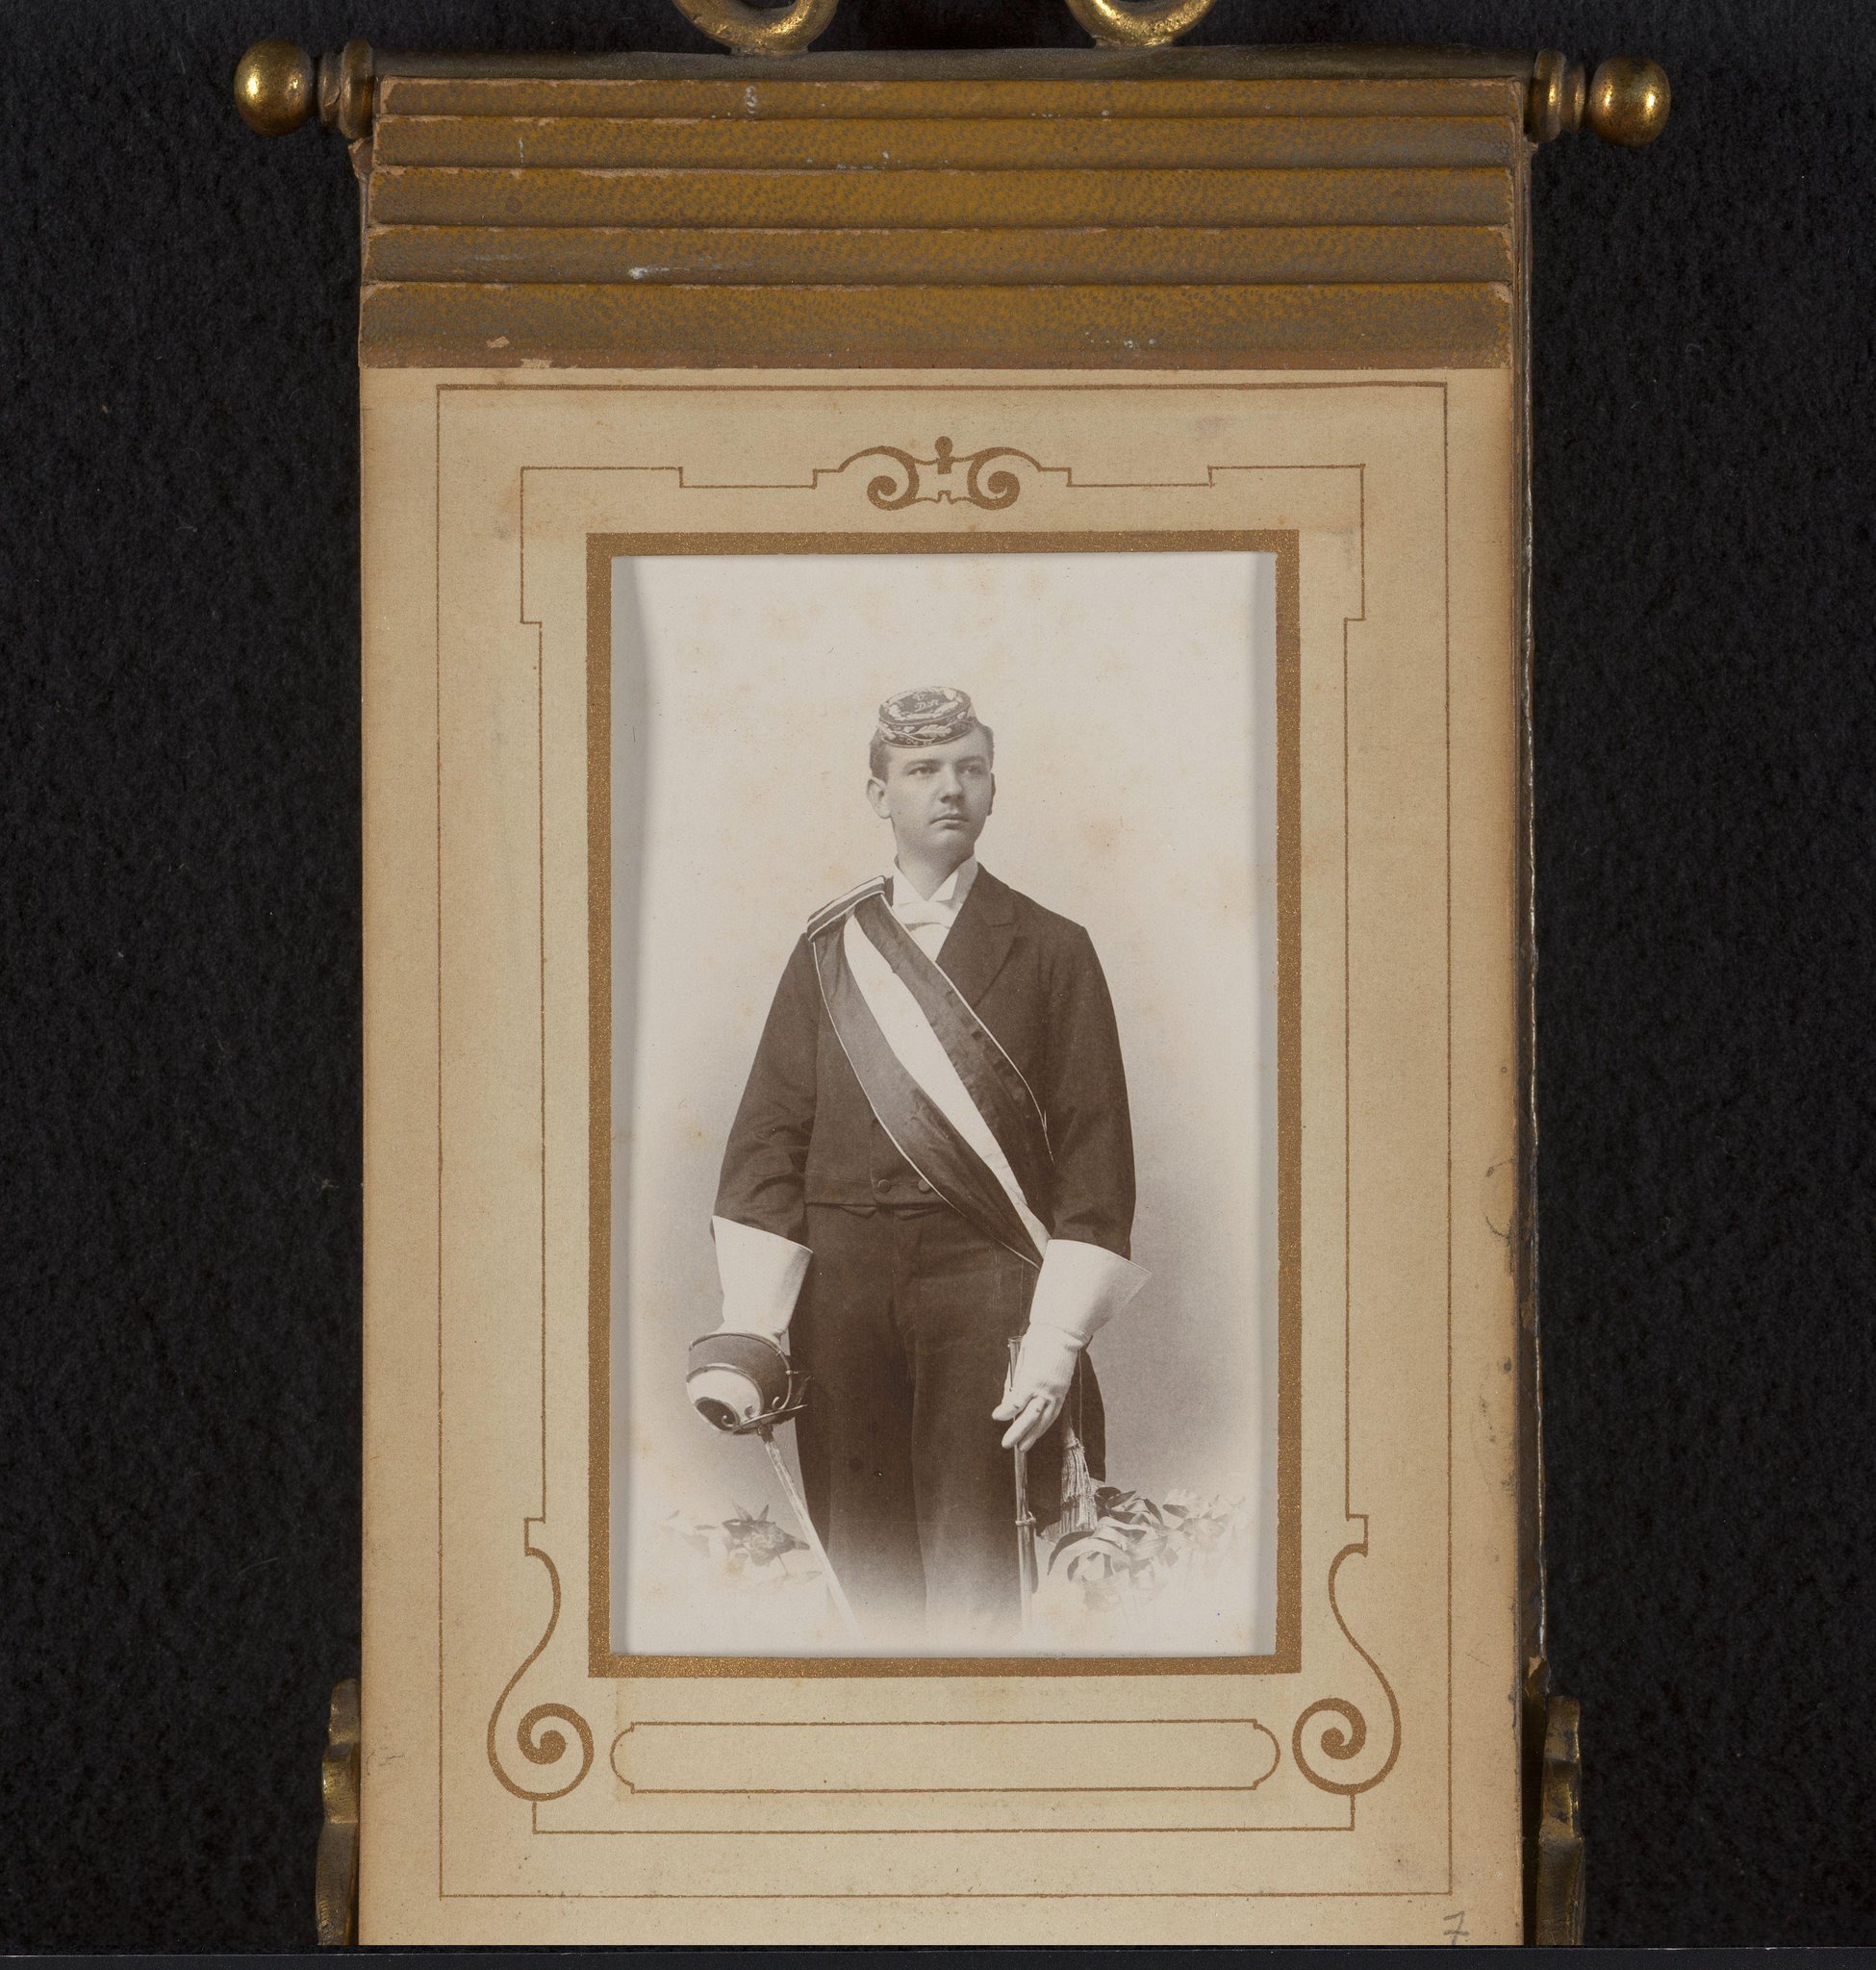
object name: album leaf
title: Portret van een jonge man in uniform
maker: otto damm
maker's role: fotograaf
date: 1897-1898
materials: cardboard, photographic support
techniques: collodion silver print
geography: marburg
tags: historical persons, youth, adolescent, (military) uniforms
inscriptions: annotation: ‘[.]aul Wollermann [...]/ s/l Ell[..]/ [...] Kohlmann [...]/ zür fur[...]/ w. 18/ Ph/ 97/98 5.’, inscription: ‘Otto Damm/ Photograph/ Marburg (Hesse[...]/ Augustiner-Str. 1.’